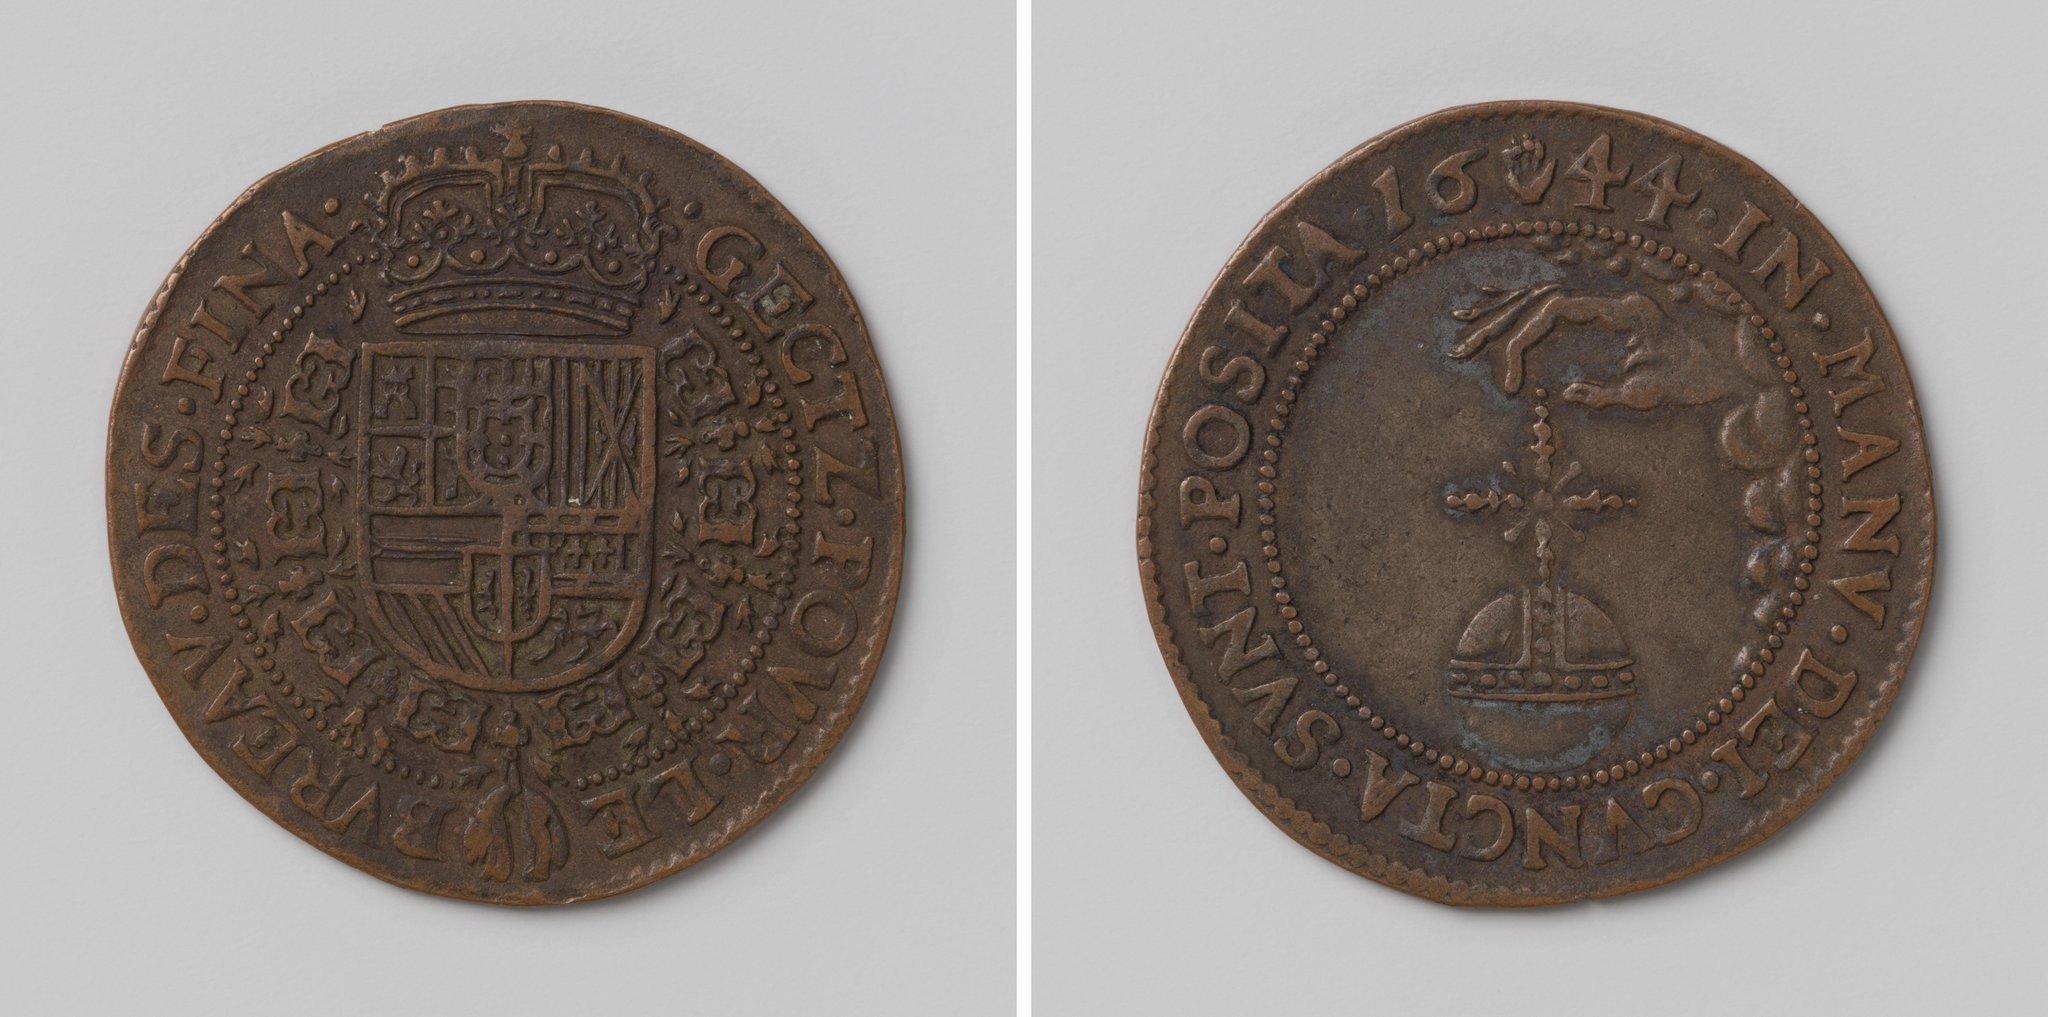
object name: jeton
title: Raad van Financiën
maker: Anonymous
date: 1644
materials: copper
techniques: striking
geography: antwerp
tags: raad van financiën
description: Koperen penning. Voorzijde: gekroond wapenschild, omhangen met de orde van het Gulden Vlies binnen omschrift. Keerzijde: hand uit wolken pakt rijksappel beet bij kruis binnen omschrift